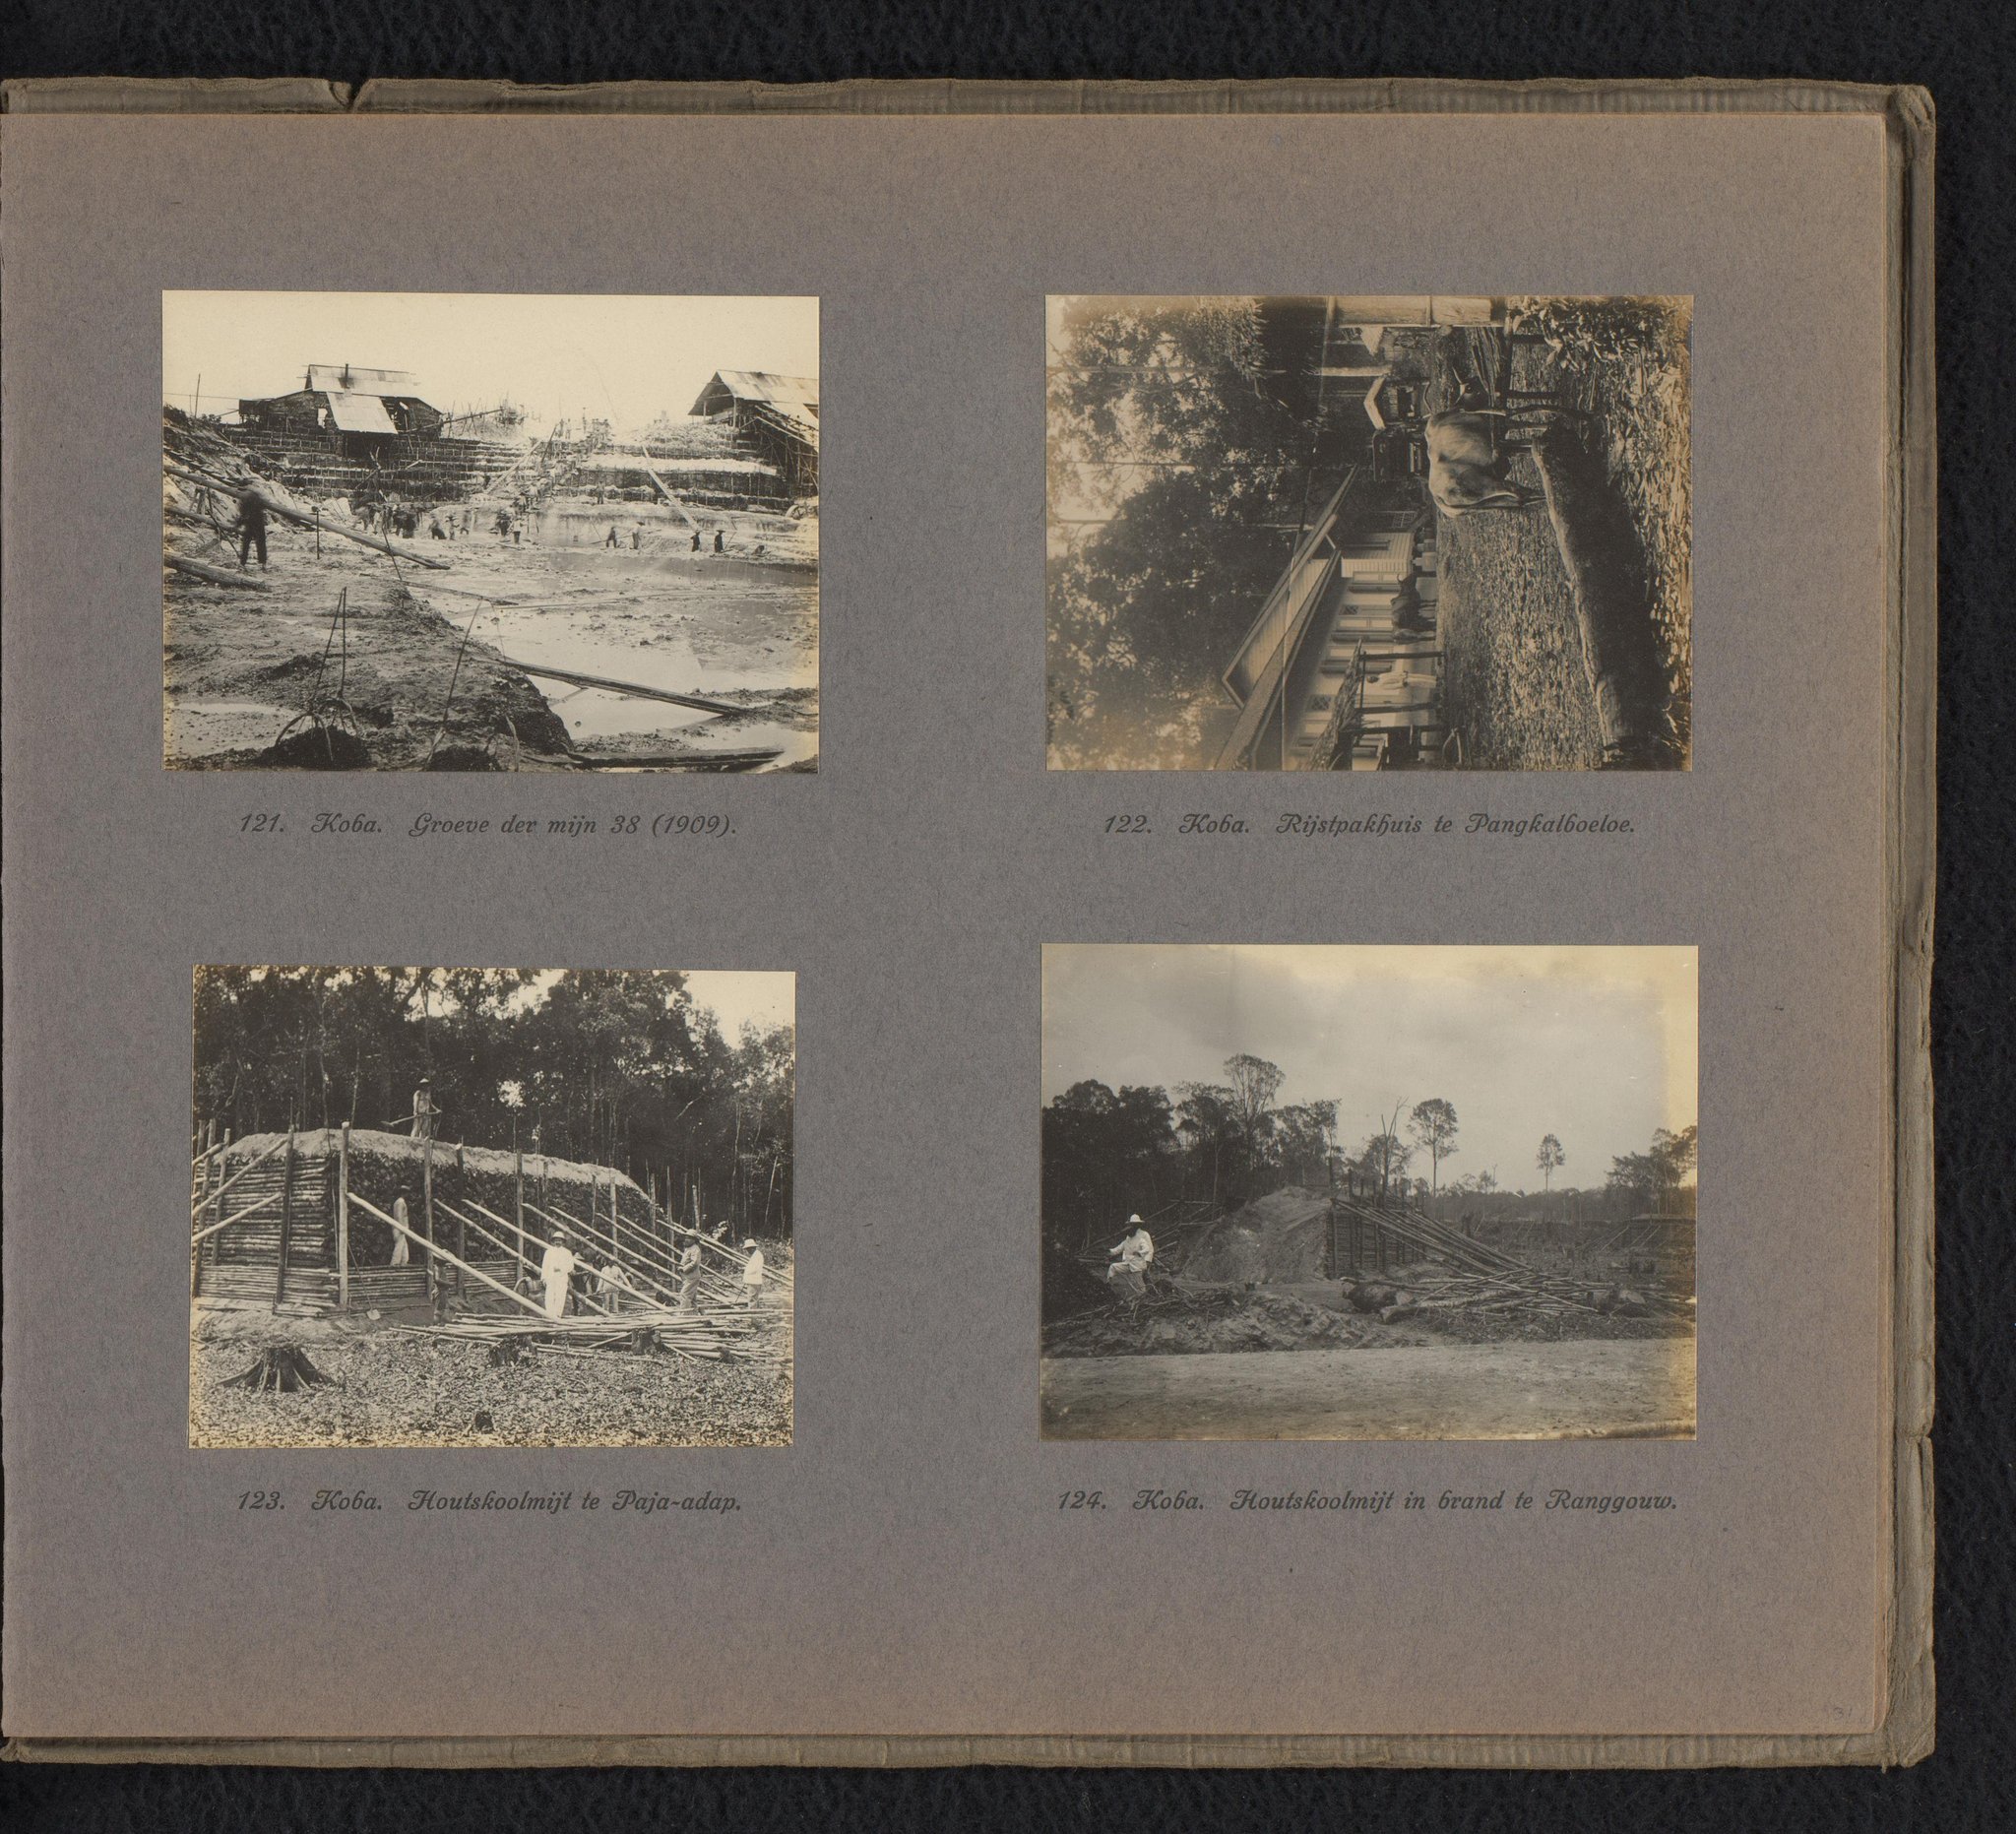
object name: photograph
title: Mijnbouw te Koba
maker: Anonymous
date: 1907-1919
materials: cardboard, photographic support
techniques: gelatin silver print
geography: bangka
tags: robert julius boers, colonial system, opencast mine; strip mining, minerals and metals: tin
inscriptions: inscription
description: Albumblad met vier foto's genummerd 121-124 van verschillende gezichten in en rond de mijnen te Koba op Banka. Onderdeel van het Banka-Album met foto's over het eiland Banka en de tinwinning door het staatsbedrijf de Banka-tinwinning in de periode ca. 1907-1919.